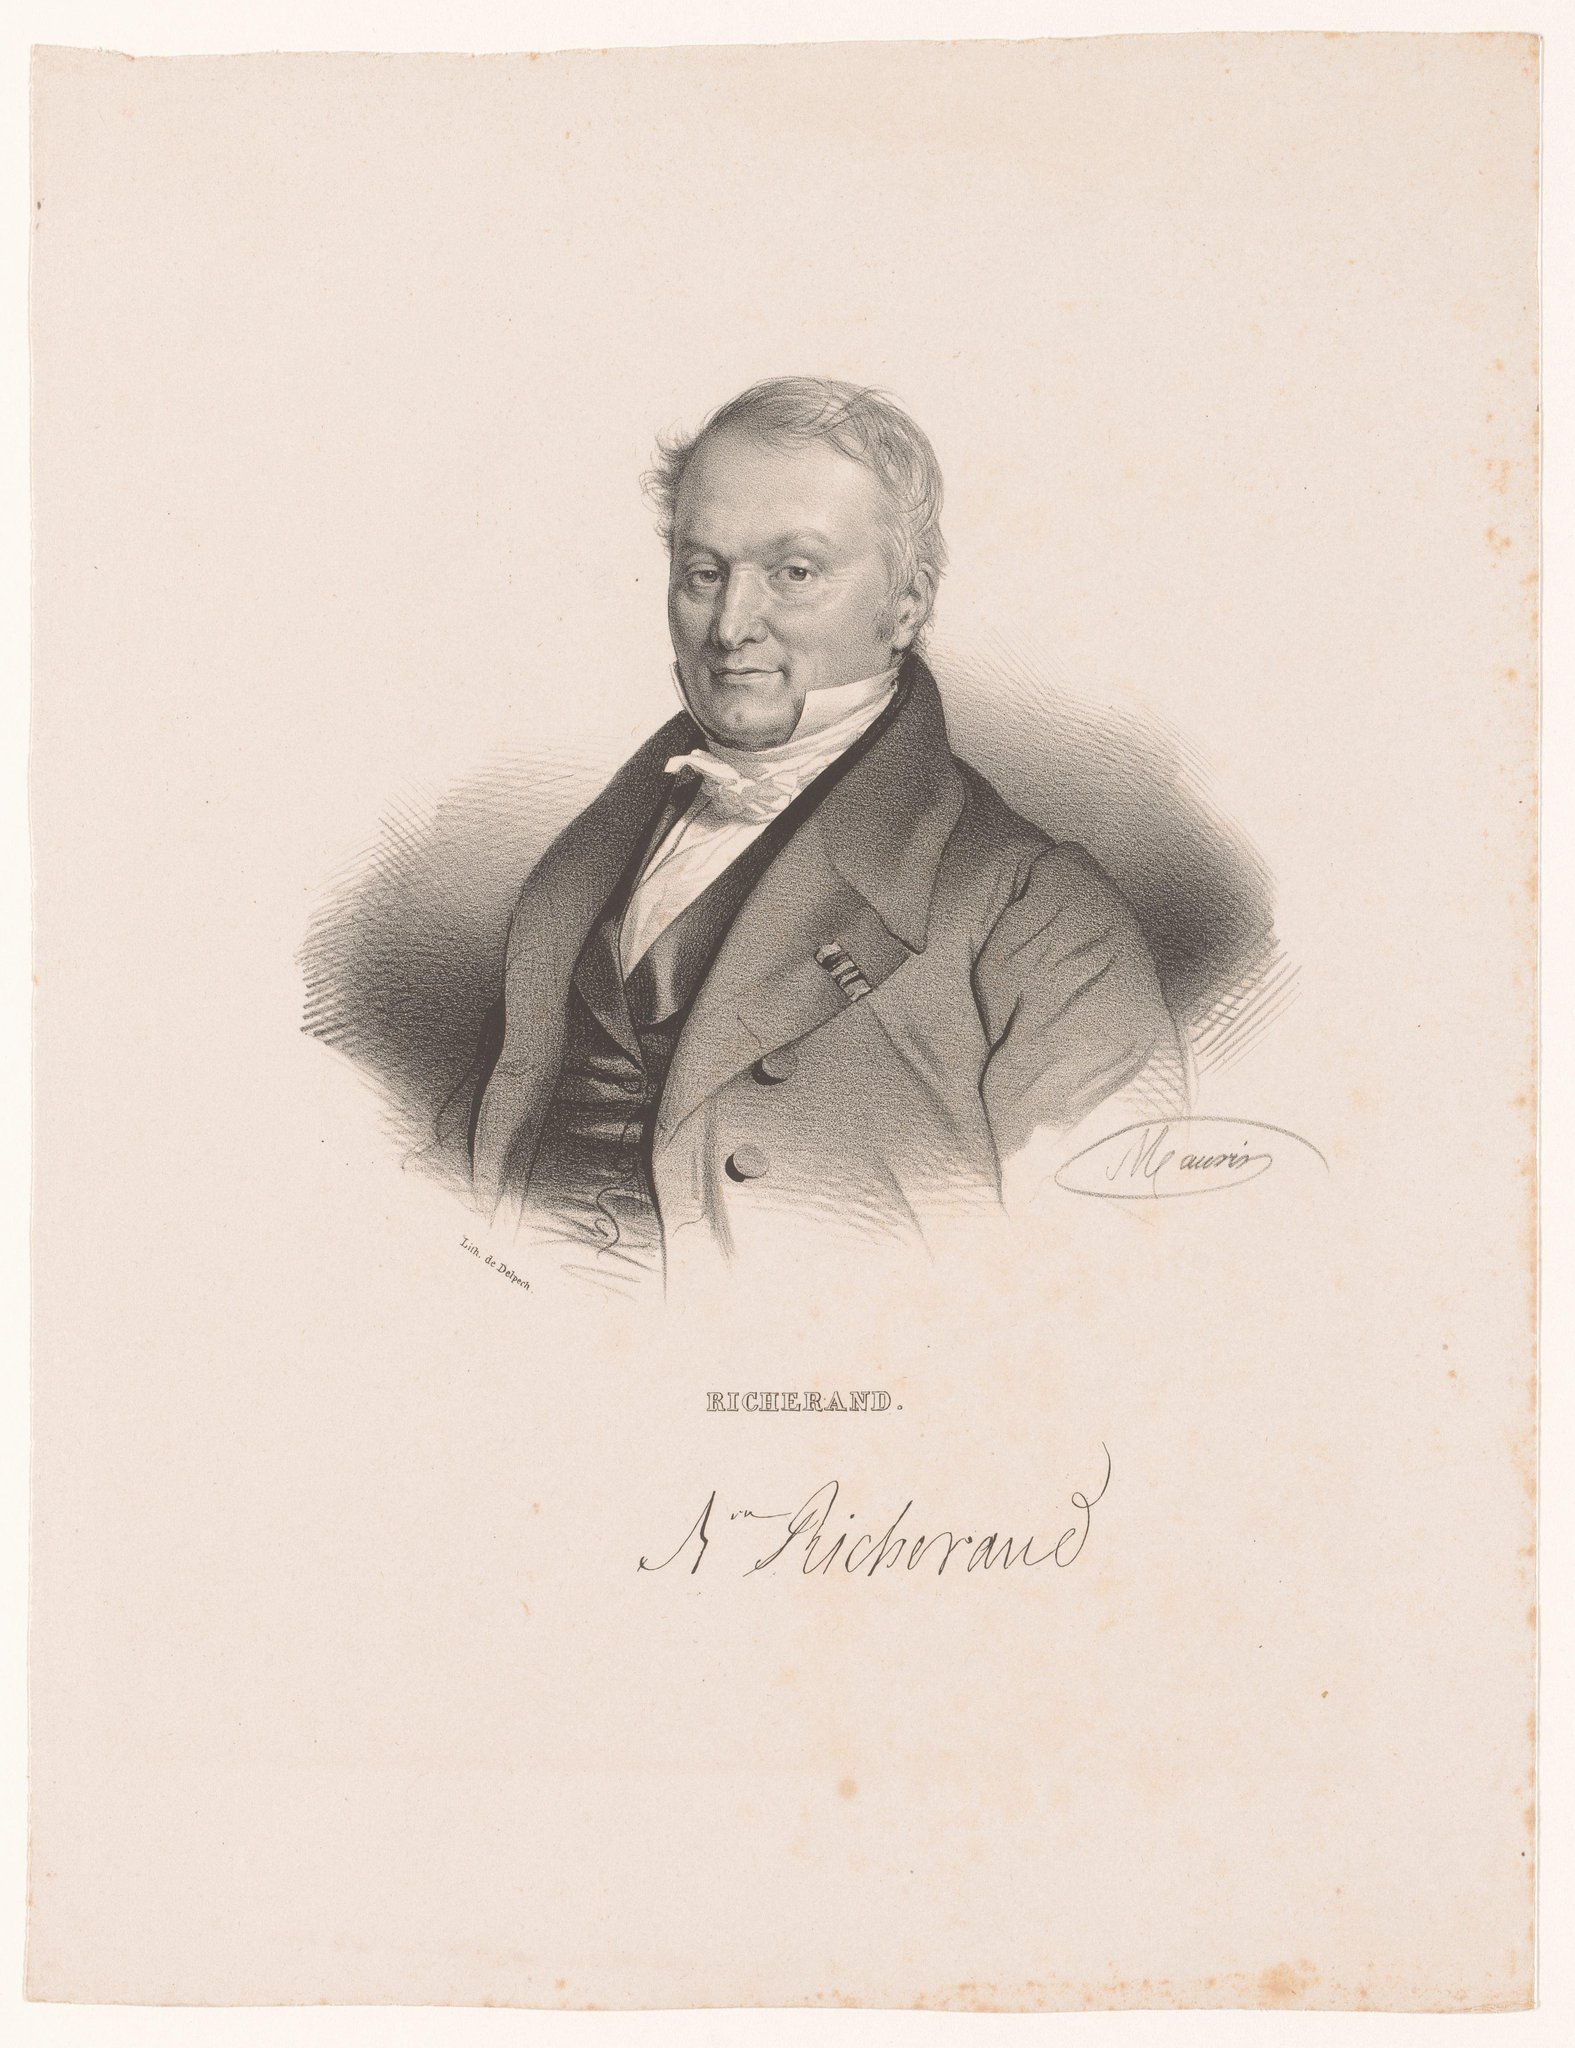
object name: print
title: Portret van Anthelme Richerand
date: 1825-1842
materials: paper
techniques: lithograph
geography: paris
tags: paris, historical persons, physician, doctor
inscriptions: collector's mark: Lugt 2228